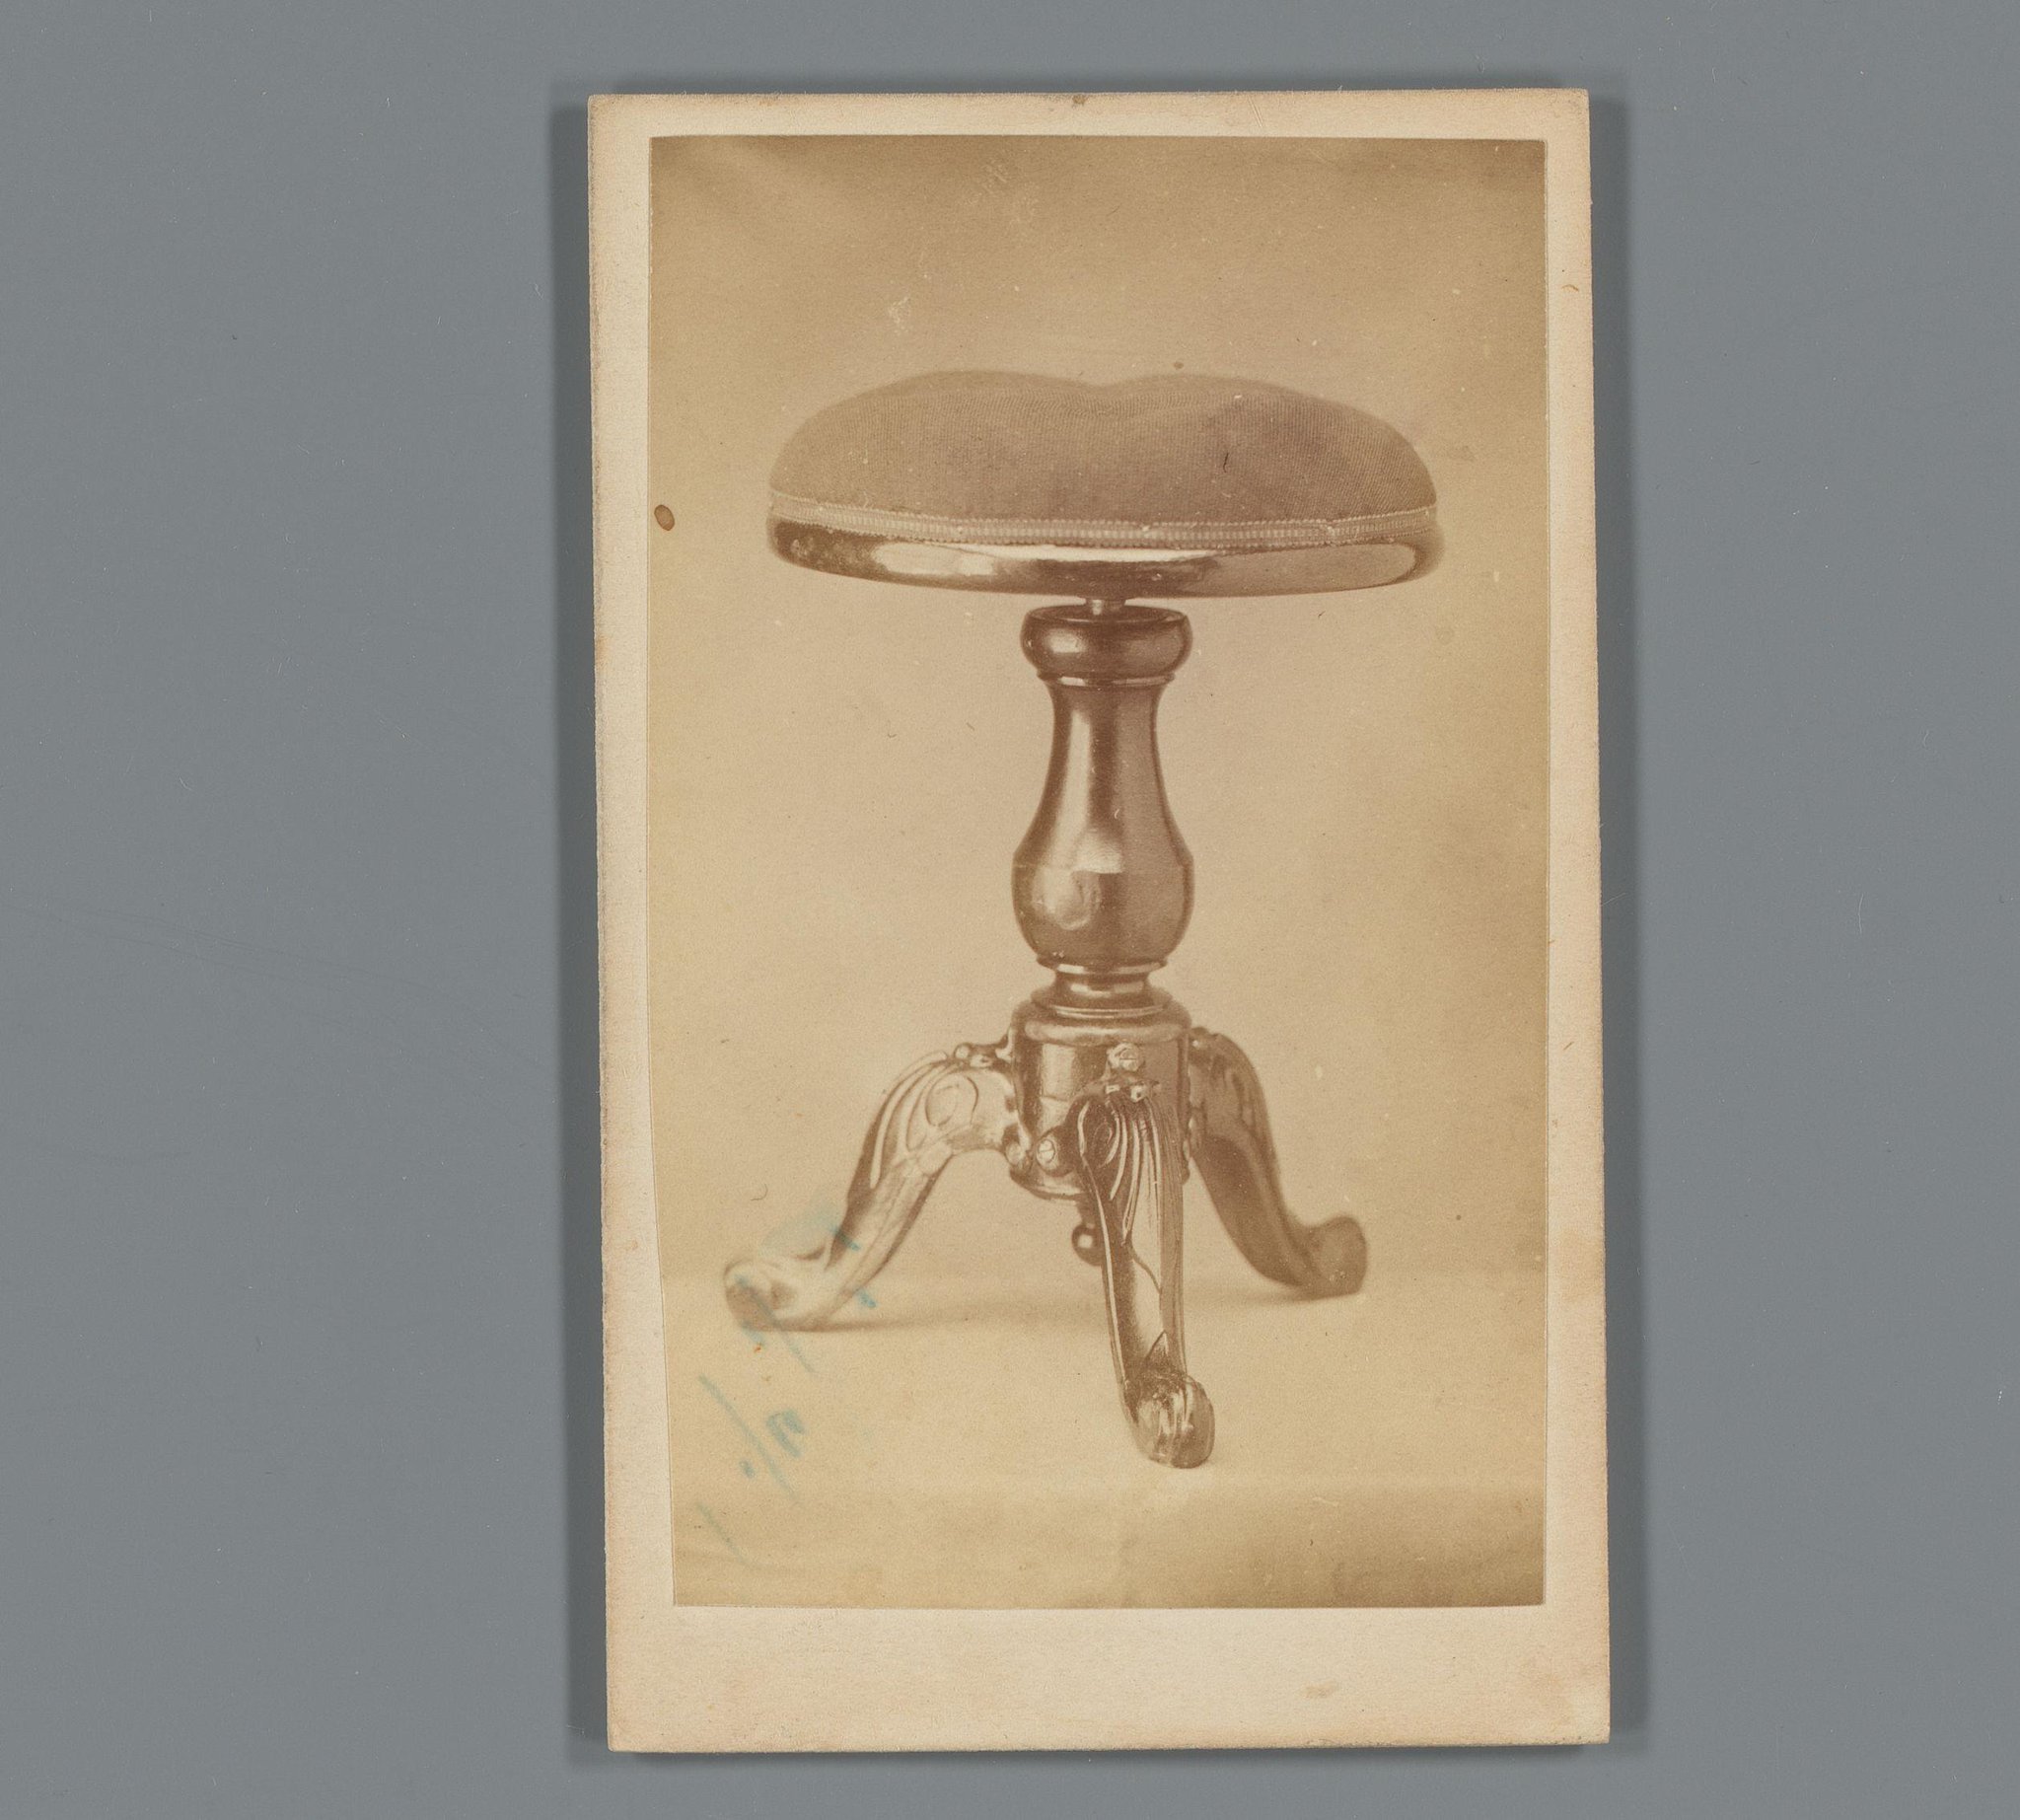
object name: photograph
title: Reclame voor een kruk van E.D. Castelow uit West Meriden, Connecticut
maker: Anonymous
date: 1850-1915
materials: cardboard, photographic support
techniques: albumen print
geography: connecticut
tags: advertising, stool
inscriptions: inscription: ‘MANUFACTURED BY/ E.D. CATELOW,/ WEST MERIDEN, CONN./ (...)’